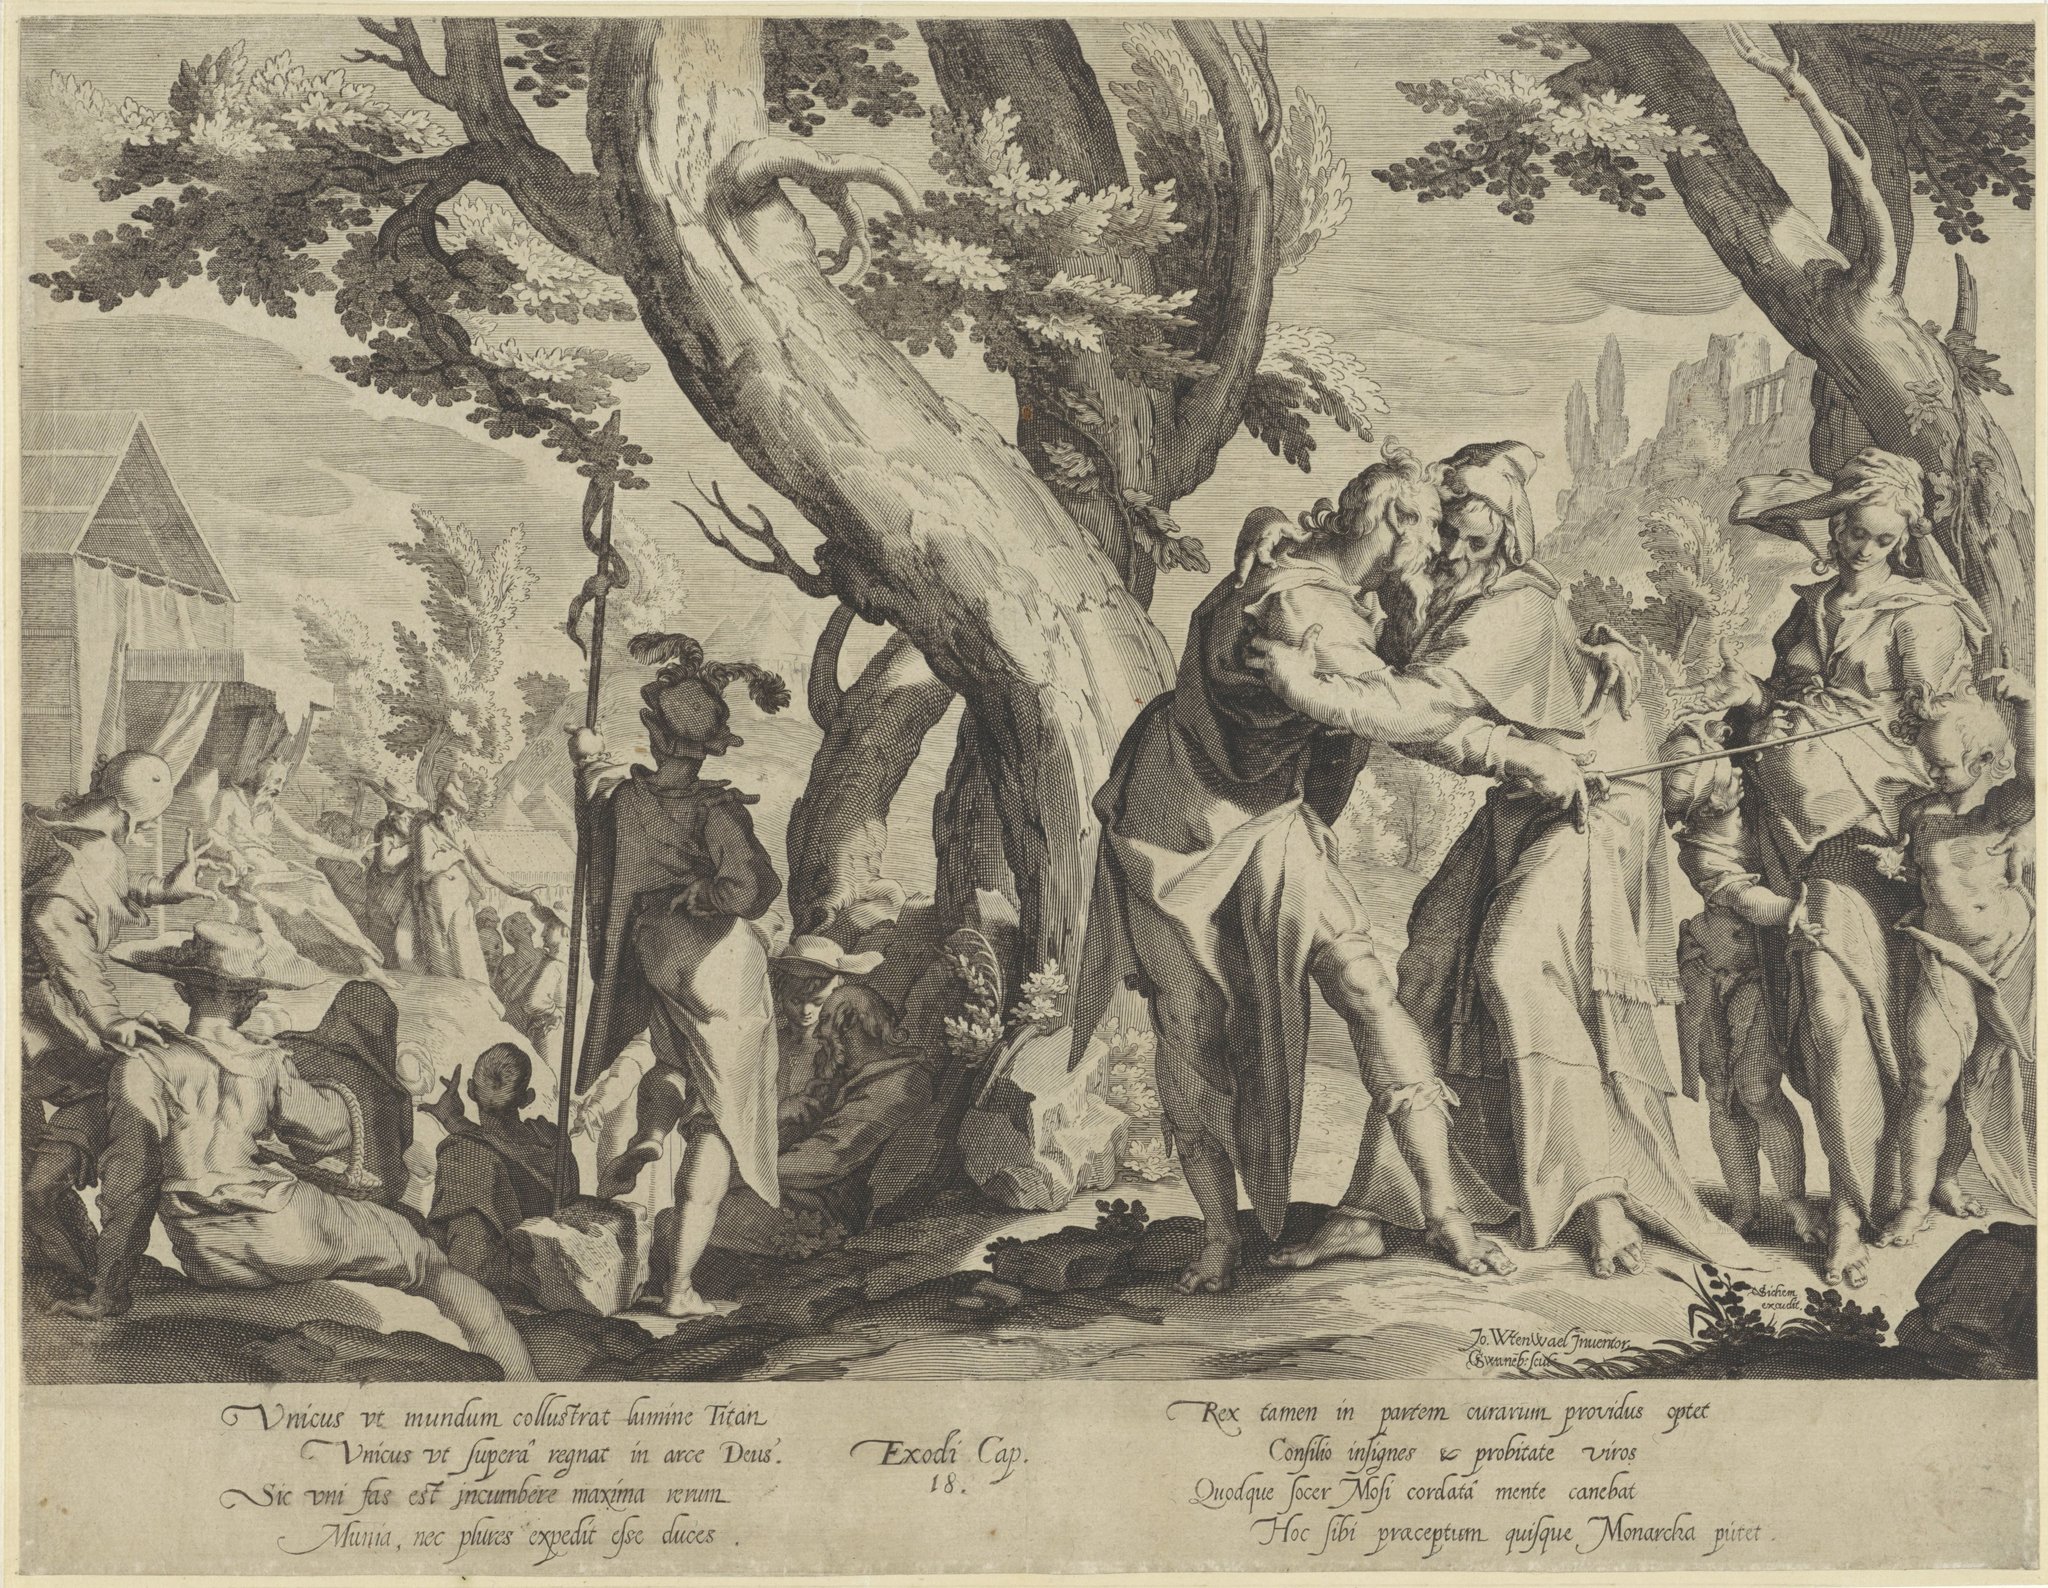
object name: print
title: Thronus Justitiae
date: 1606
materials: paper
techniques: engraving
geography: leiden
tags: jethro's visit to moses: with zipporah and her two sons he comes to the desert where moses is encamped (exodus 18), juridical examples; exemplary judges; 'gerechtigkeitsbilder'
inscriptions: collector's mark: Lugt 240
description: Jetro, de schoonvader van Mozes, bezoekt hem in de woestijn en geeft hem advies over de organisatie van de rechtspraak. De twee omhelzen elkaar. Jetro heeft Mozes' vrouw, zijn dochter Sippora, en haar twee zonen meegenomen. Zij staan rechts. Links spreekt Mozes recht over het volk Israël. Onder de voorstelling twee vierregelige verzen in het Latijn en een verwijzing naar de Bijbeltekst in Ex. 18.